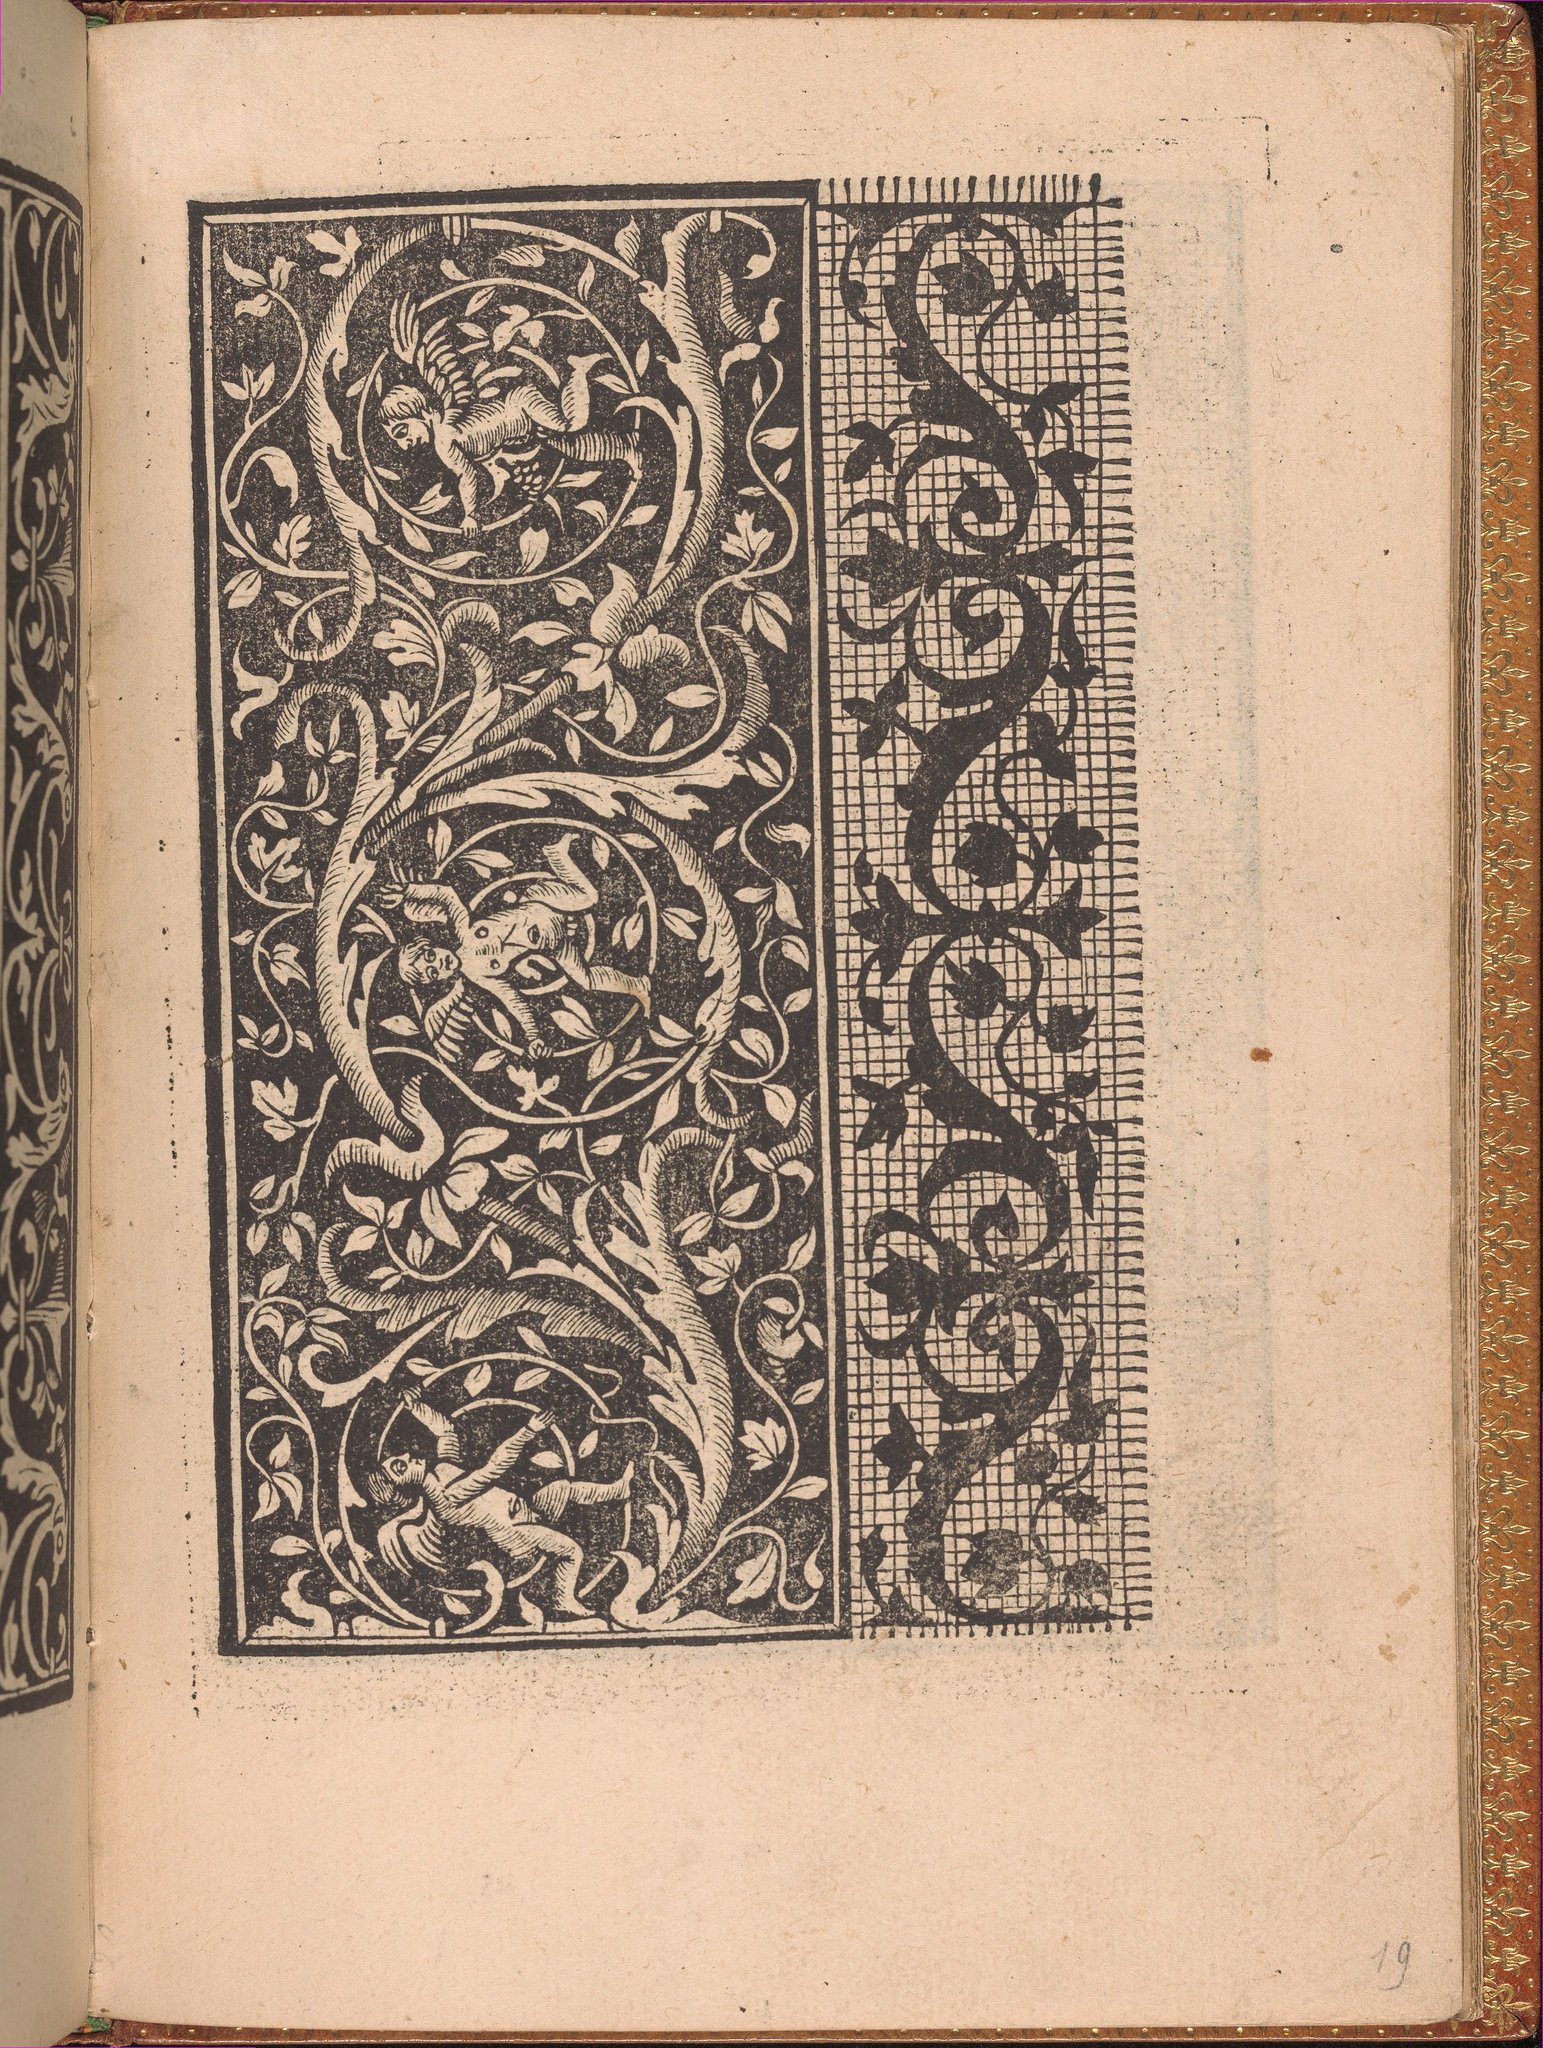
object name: book print ornament architecture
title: Convivio delle Belle Donne, page 19 (recto)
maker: nicolò zoppino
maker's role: publisher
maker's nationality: italian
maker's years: 1478-1544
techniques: woodcut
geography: italy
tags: flowers